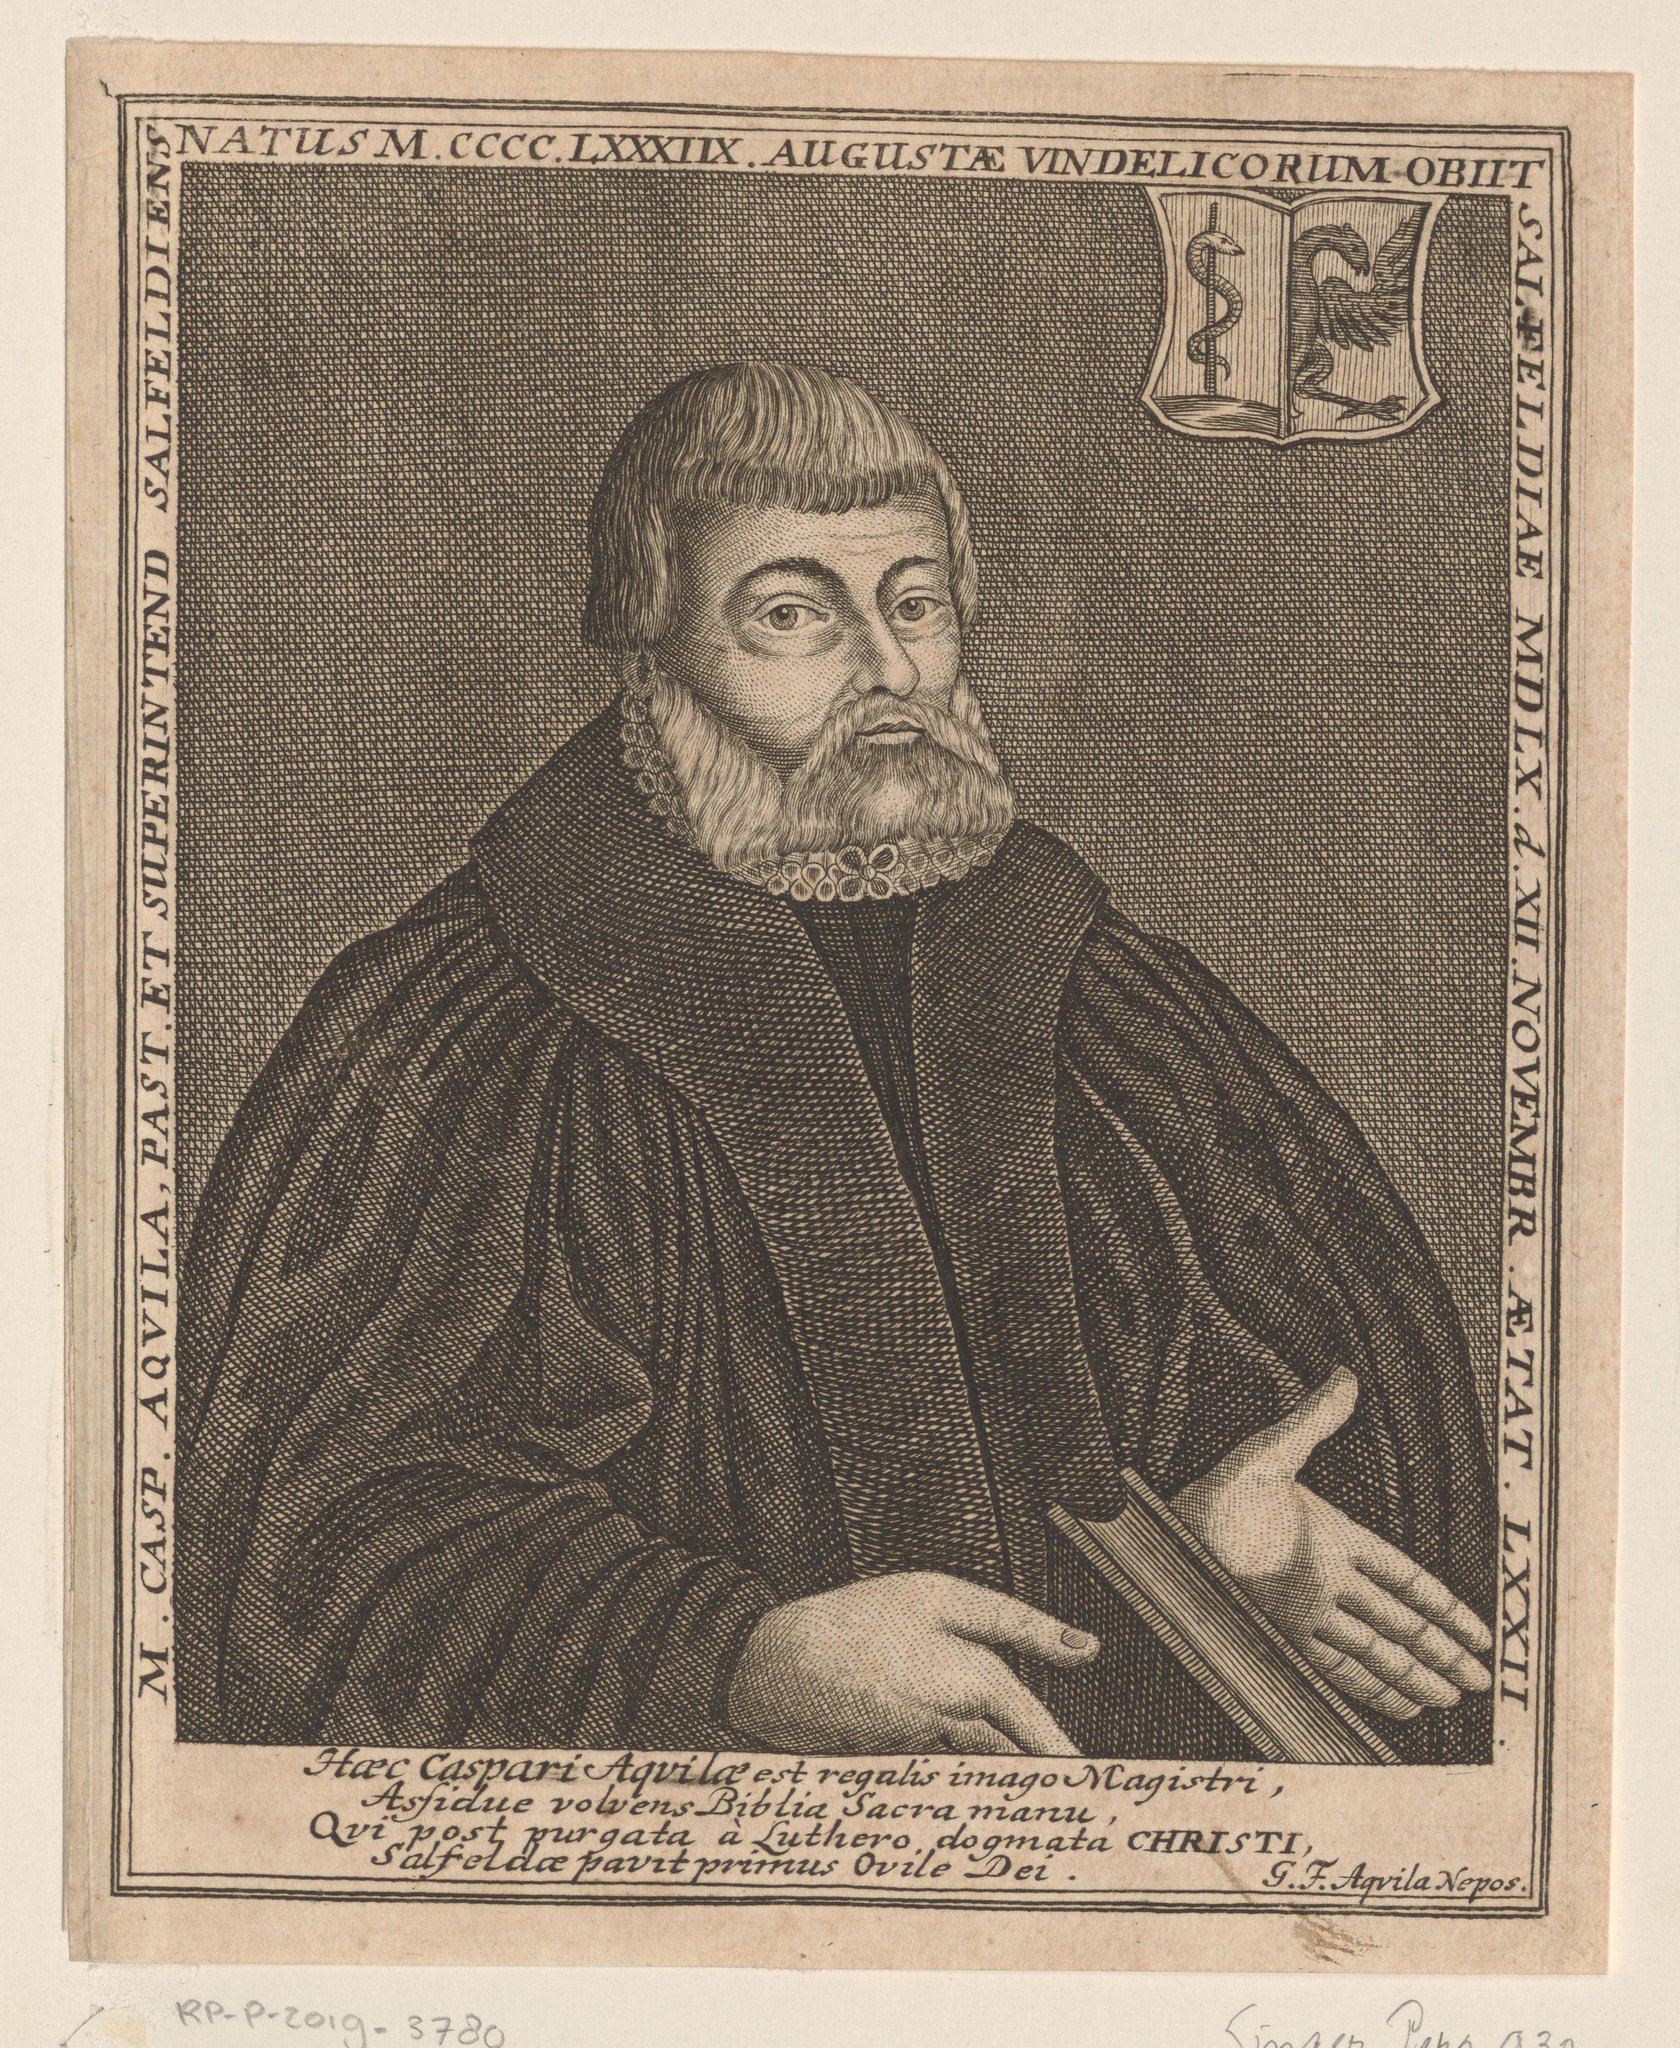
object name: print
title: Portret van Caspar Aquila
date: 1600-1649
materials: paper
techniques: engraving, etching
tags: theologian, historical persons, armorial bearing, heraldry